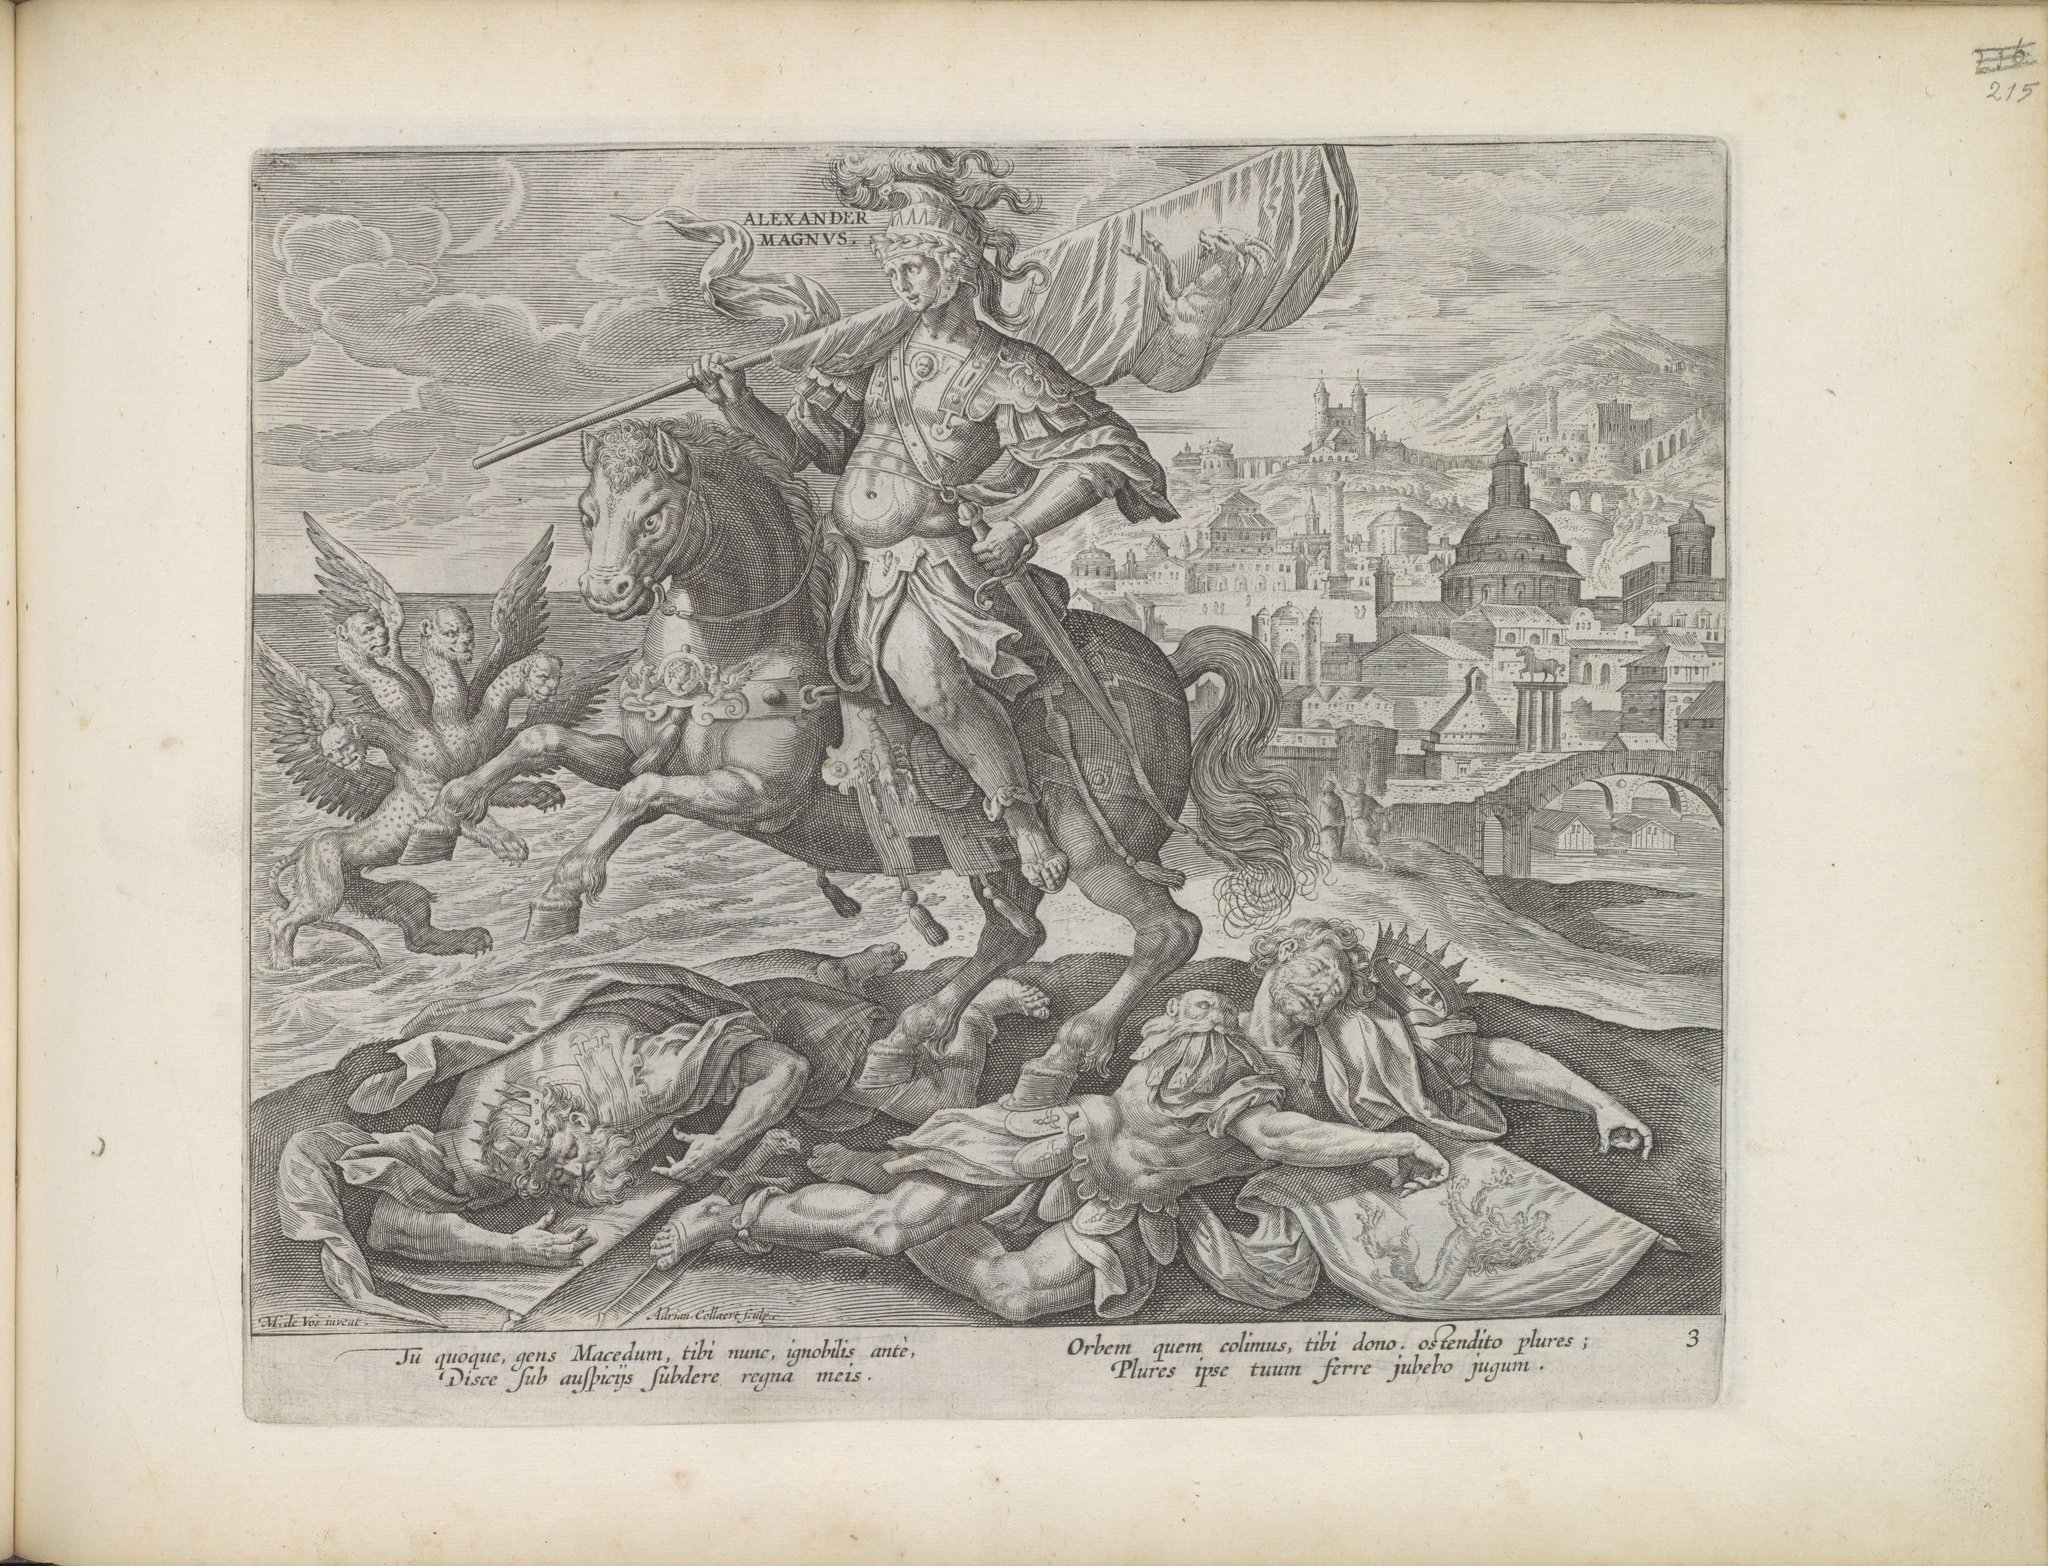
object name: album leaf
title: Theatrum Biblicum Hoc Est Historiae Sacrae Veteris et Novi Testamenti Tabulis Aeneis Expressae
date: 1570-1618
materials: paper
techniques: engraving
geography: amsterdam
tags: (story of) alexander the great, the world empires symbolized by four beasts (daniel ch. 7), the leopard with four bird's wings and four heads ~ daniel's visions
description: Alexander de Grote rijdt op een paard, in zijn hand een vlag met de afbeelding van een berggeit (Griekenland). Het paard vertrapt koning Cyrus van Perzië en Ninus van Babylonië. Op de achtergrond een stadsgezicht. Naast Ninus komt uit de zee een vierkoppige luipaard met vleugels tevoorschijn, een verwijzing naar een visioen van Daniël over de opkomst van vier koninkrijken in de wereld. Onder de voorstelling een verwijzing in het Latijn naar de Bijbeltekst in Dan. 7. Deze prent maakt deel uit van een album.